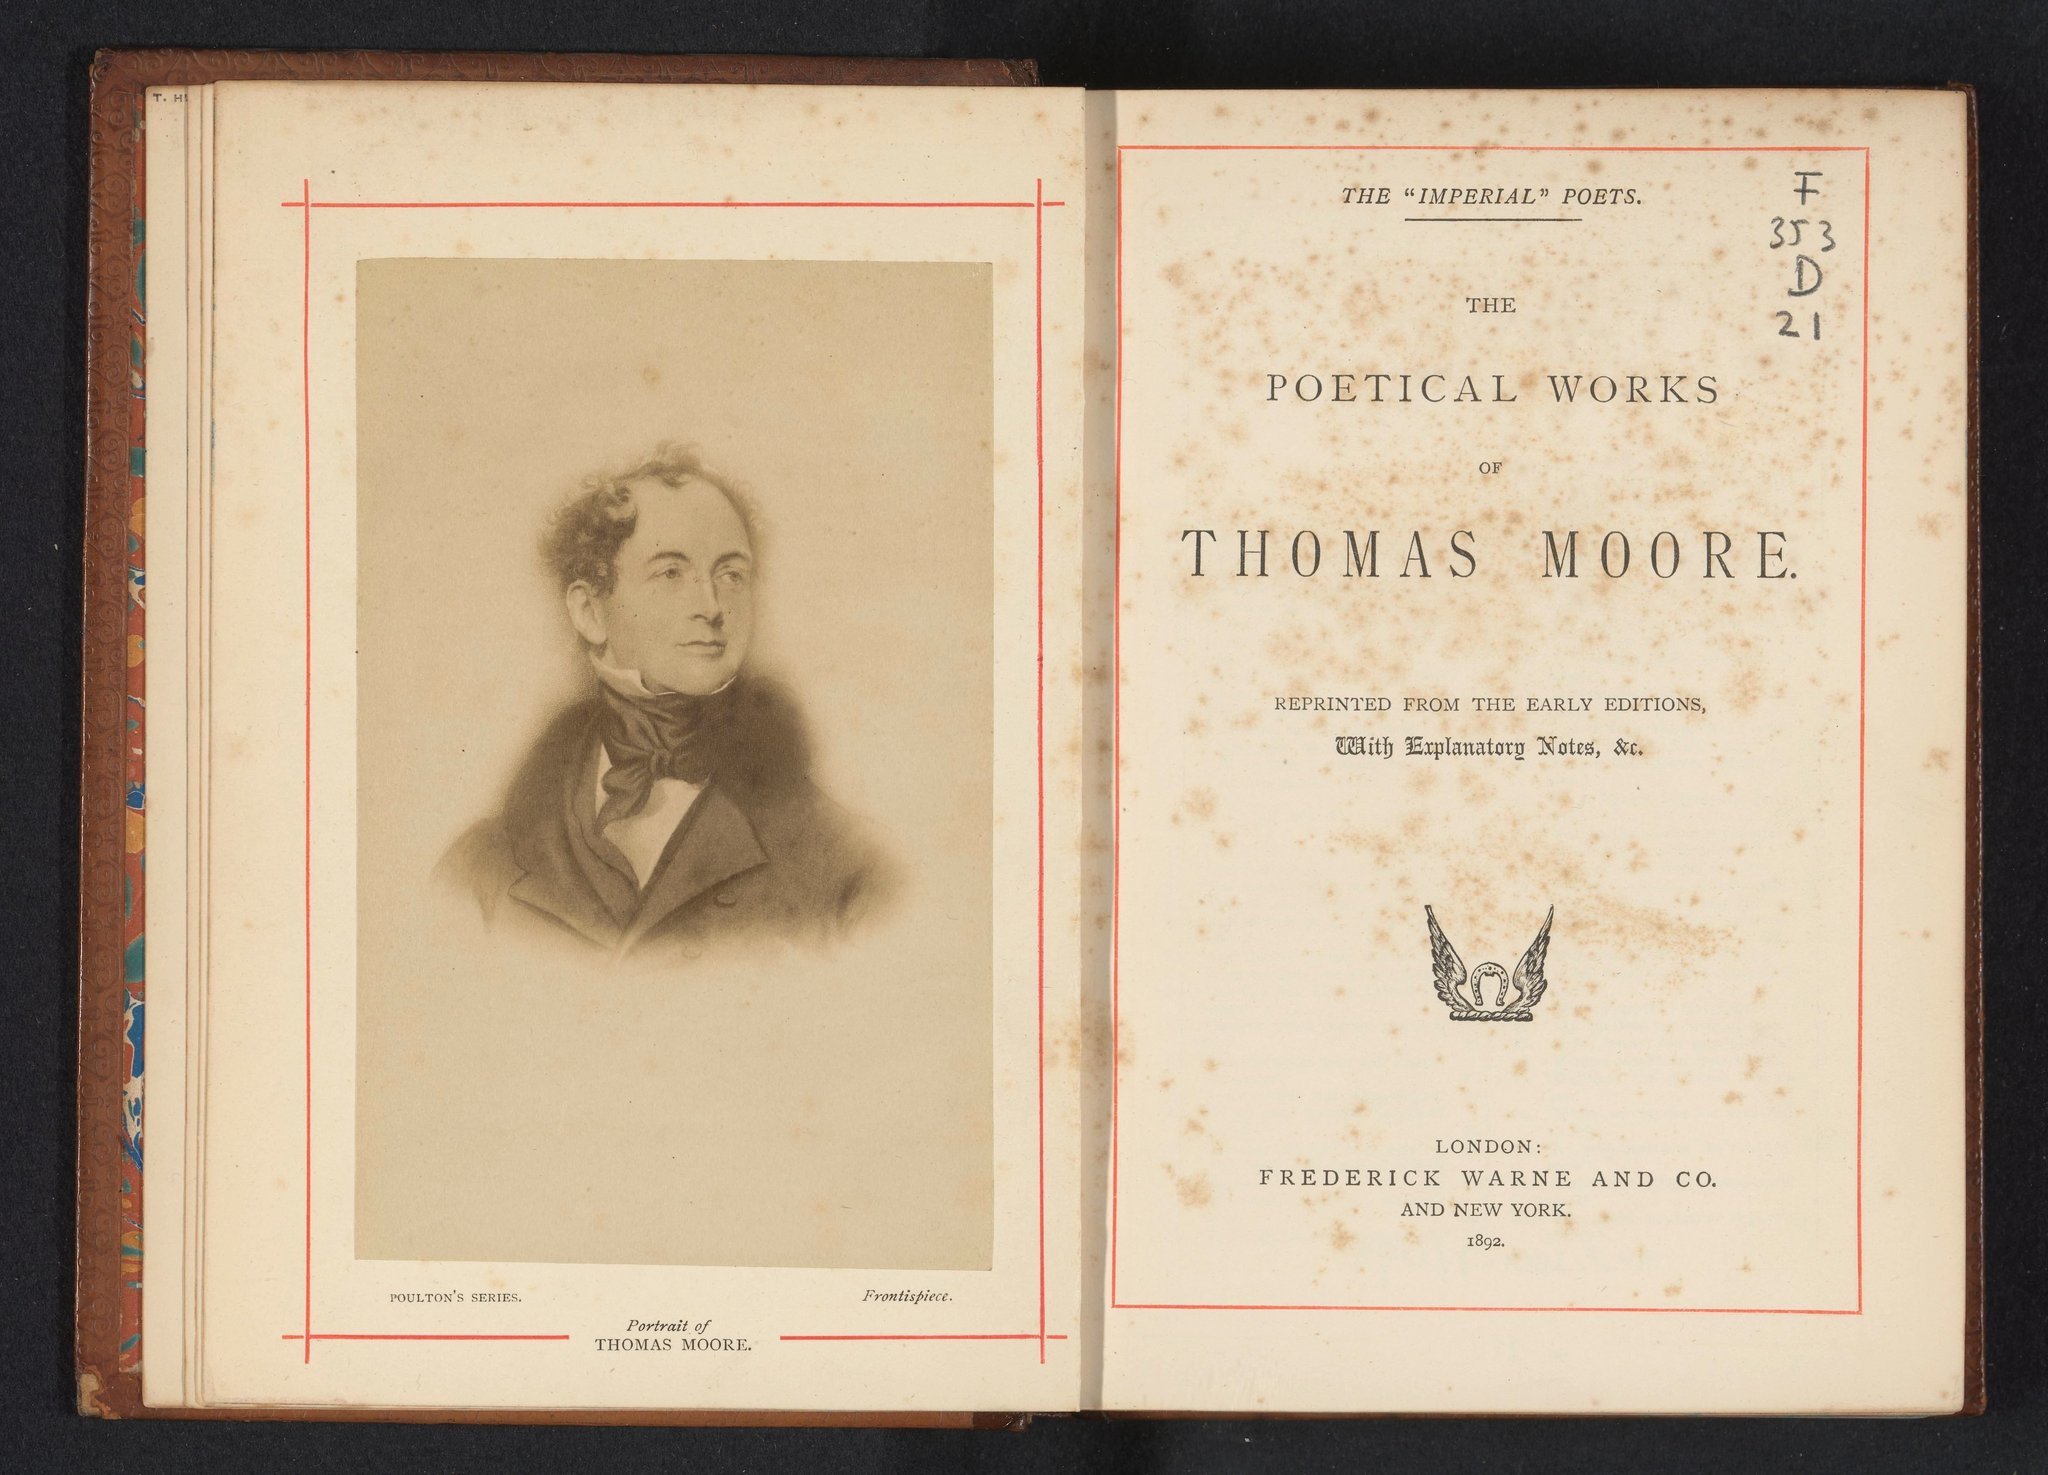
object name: photograph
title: Portrait of Thomas Moore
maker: Anonymous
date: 1882-1892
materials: photographic support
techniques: albumen print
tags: thomas moore, portrait of a writer